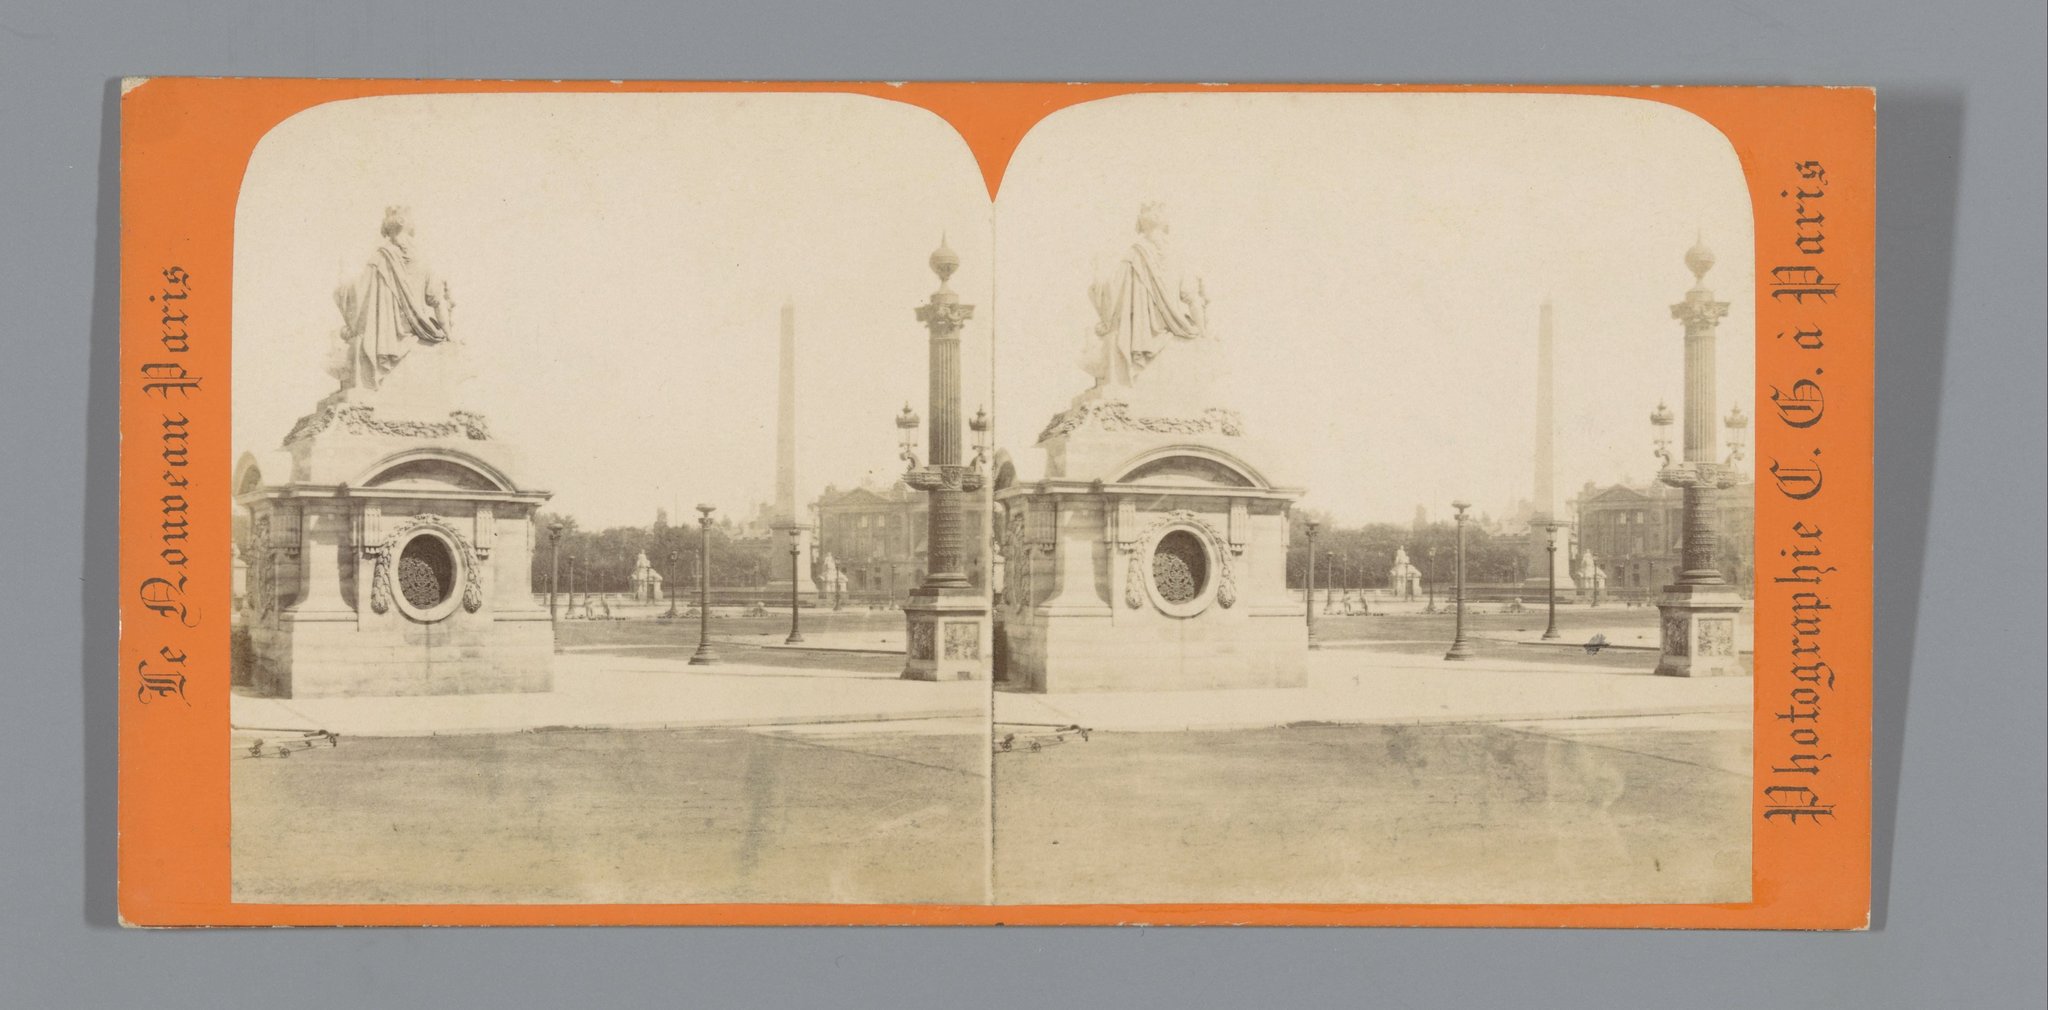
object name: stereograph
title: Gezicht op het Place de la Concorde te Parijs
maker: charles gérard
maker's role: fotograaf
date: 1860-1870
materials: cardboard, photographic support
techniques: albumen print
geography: paris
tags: square, place, circus, etc.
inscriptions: inscription: ‘Photographie C. G. à Paris.’, inscription: ‘Place de la Concorde’